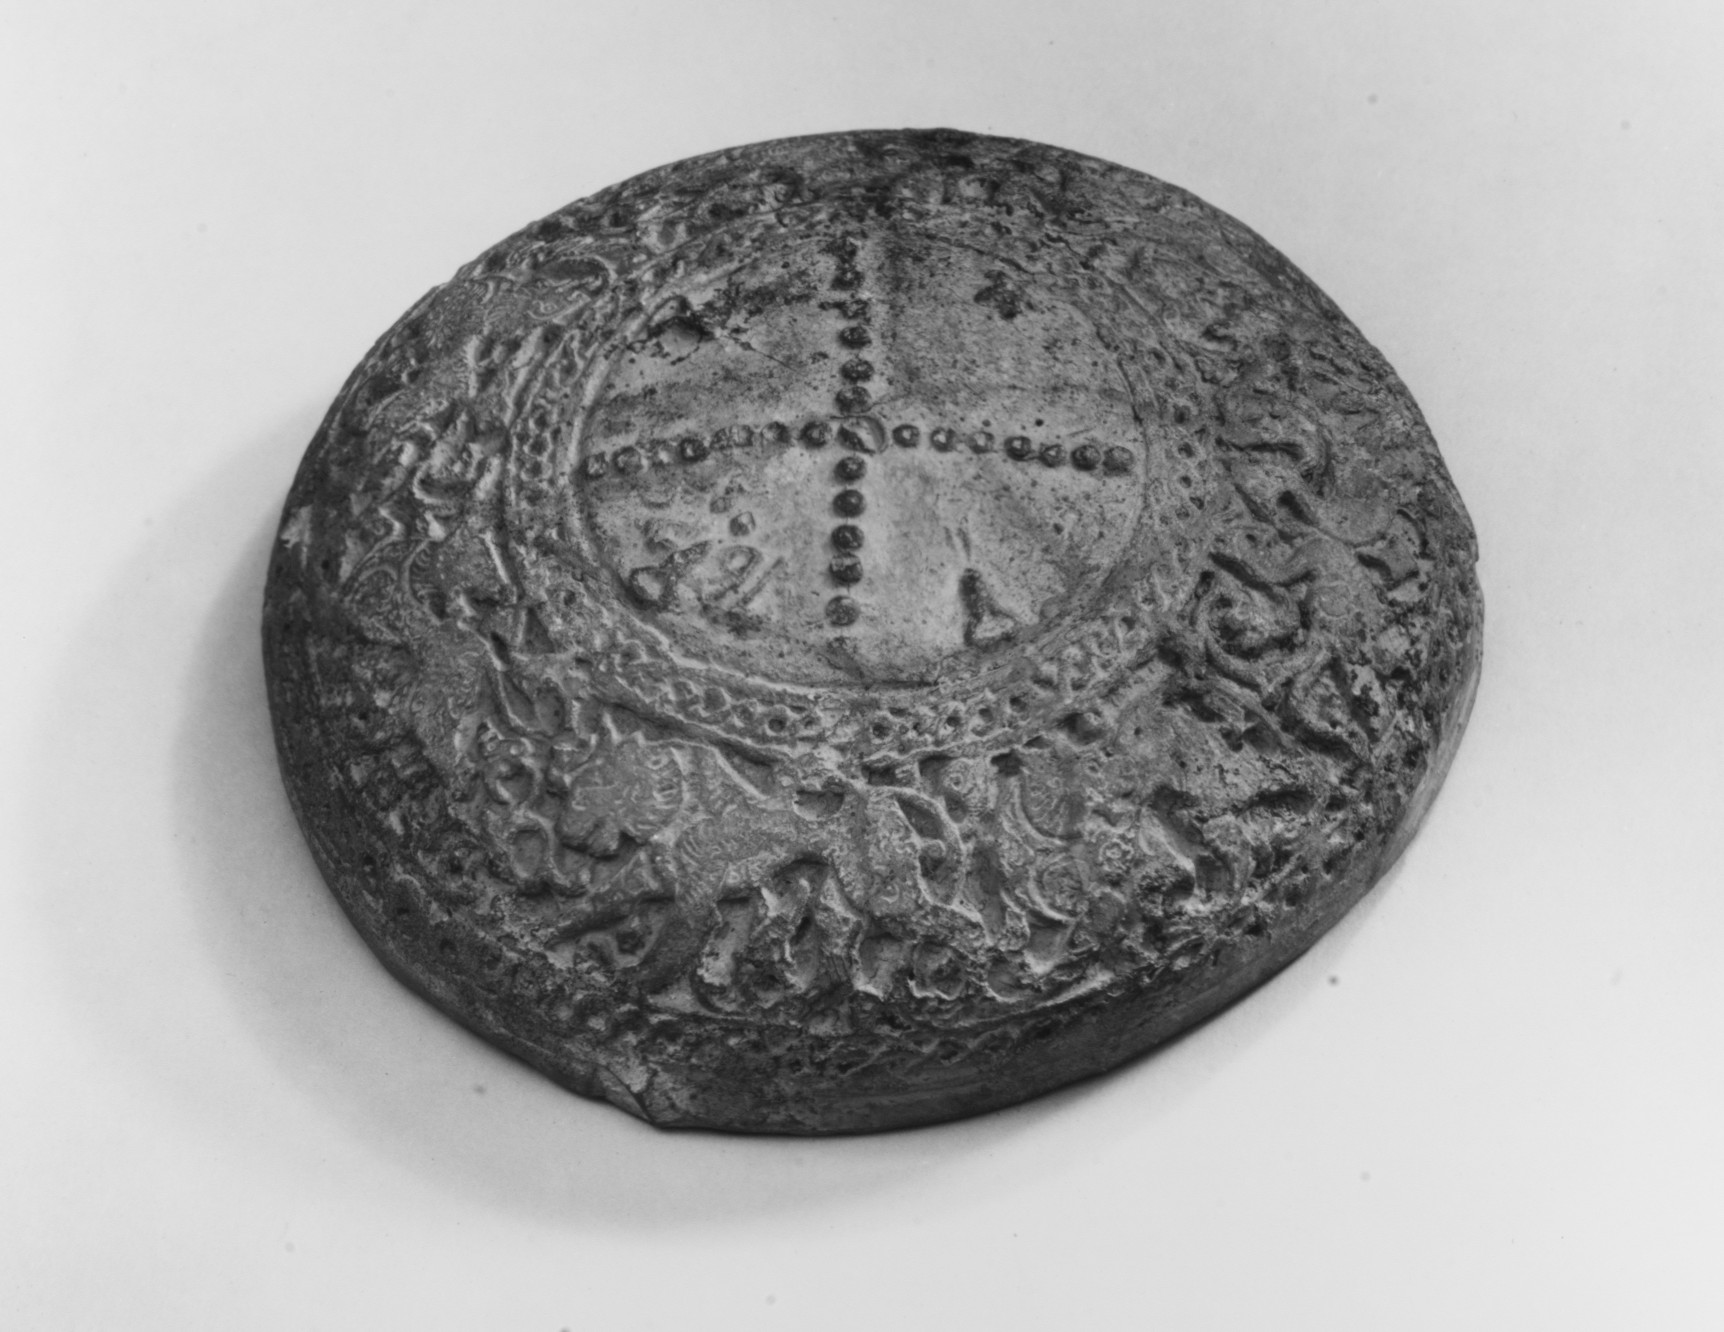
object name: fragment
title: Fragment of Bottle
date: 1201-1400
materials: earthenware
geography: iran